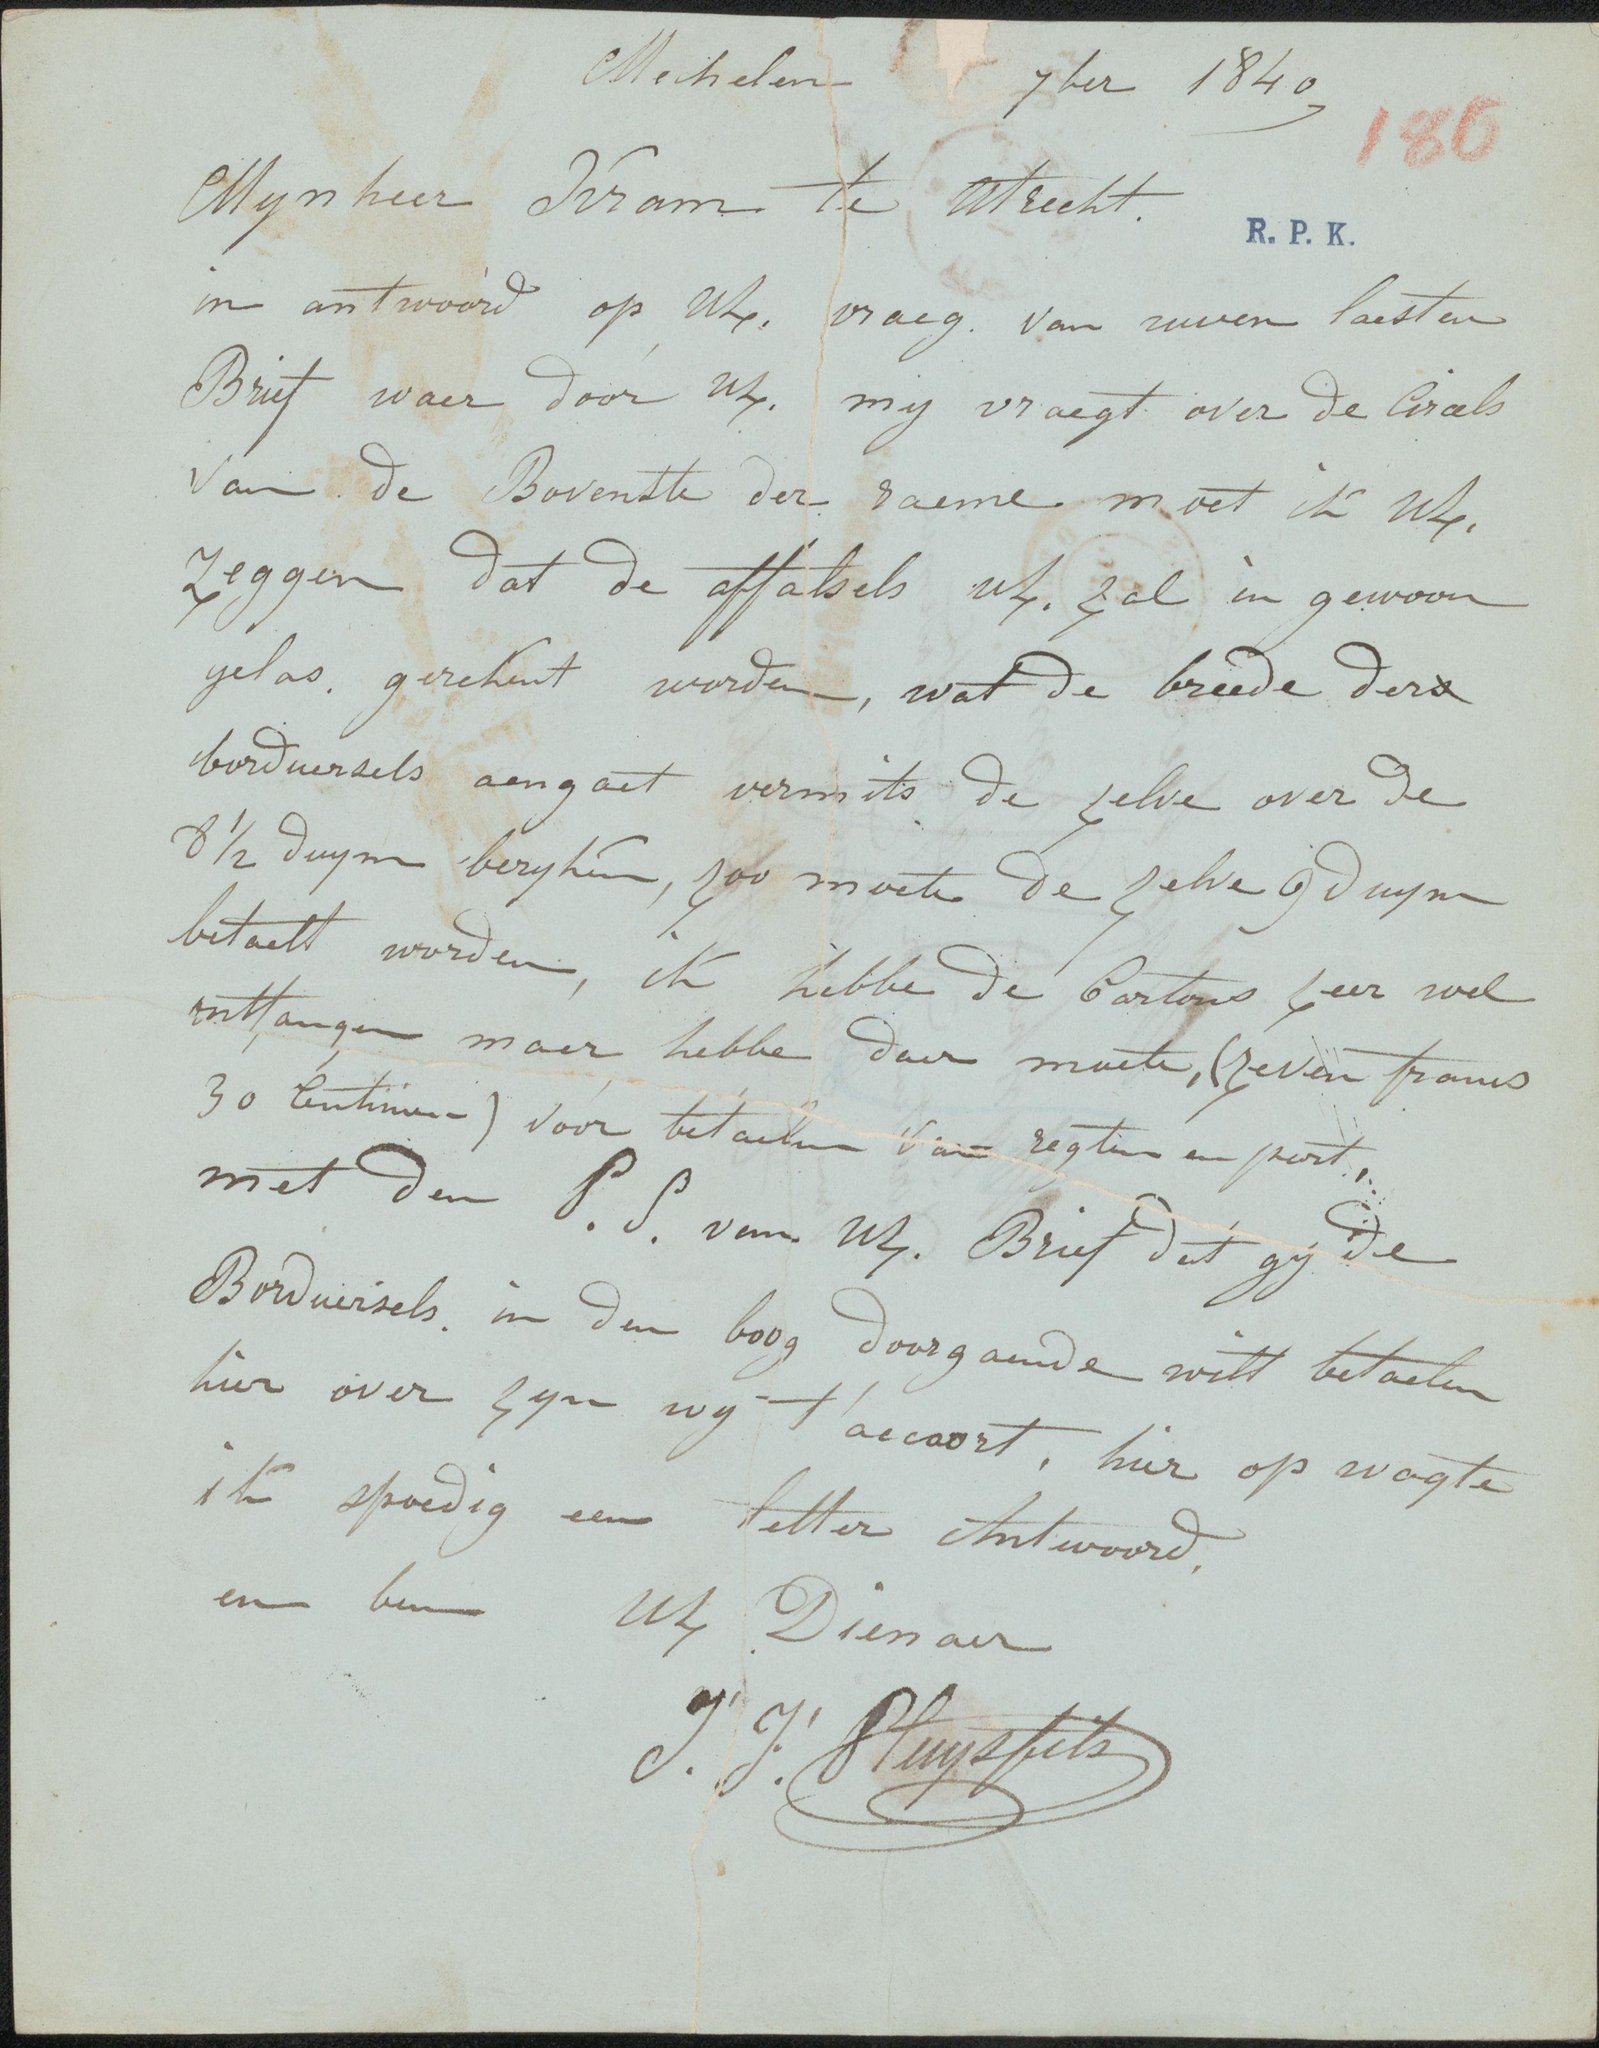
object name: letter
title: Brief aan Christiaan Kramm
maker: jan frans pluys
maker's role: sculptor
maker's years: 1810-1873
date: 1840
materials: ink, paper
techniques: pen, writing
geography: mechelen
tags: draughtsman, christiaan kramm, applied arts, arts and crafts; industrial design, money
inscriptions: collector's mark: Lugt 2233